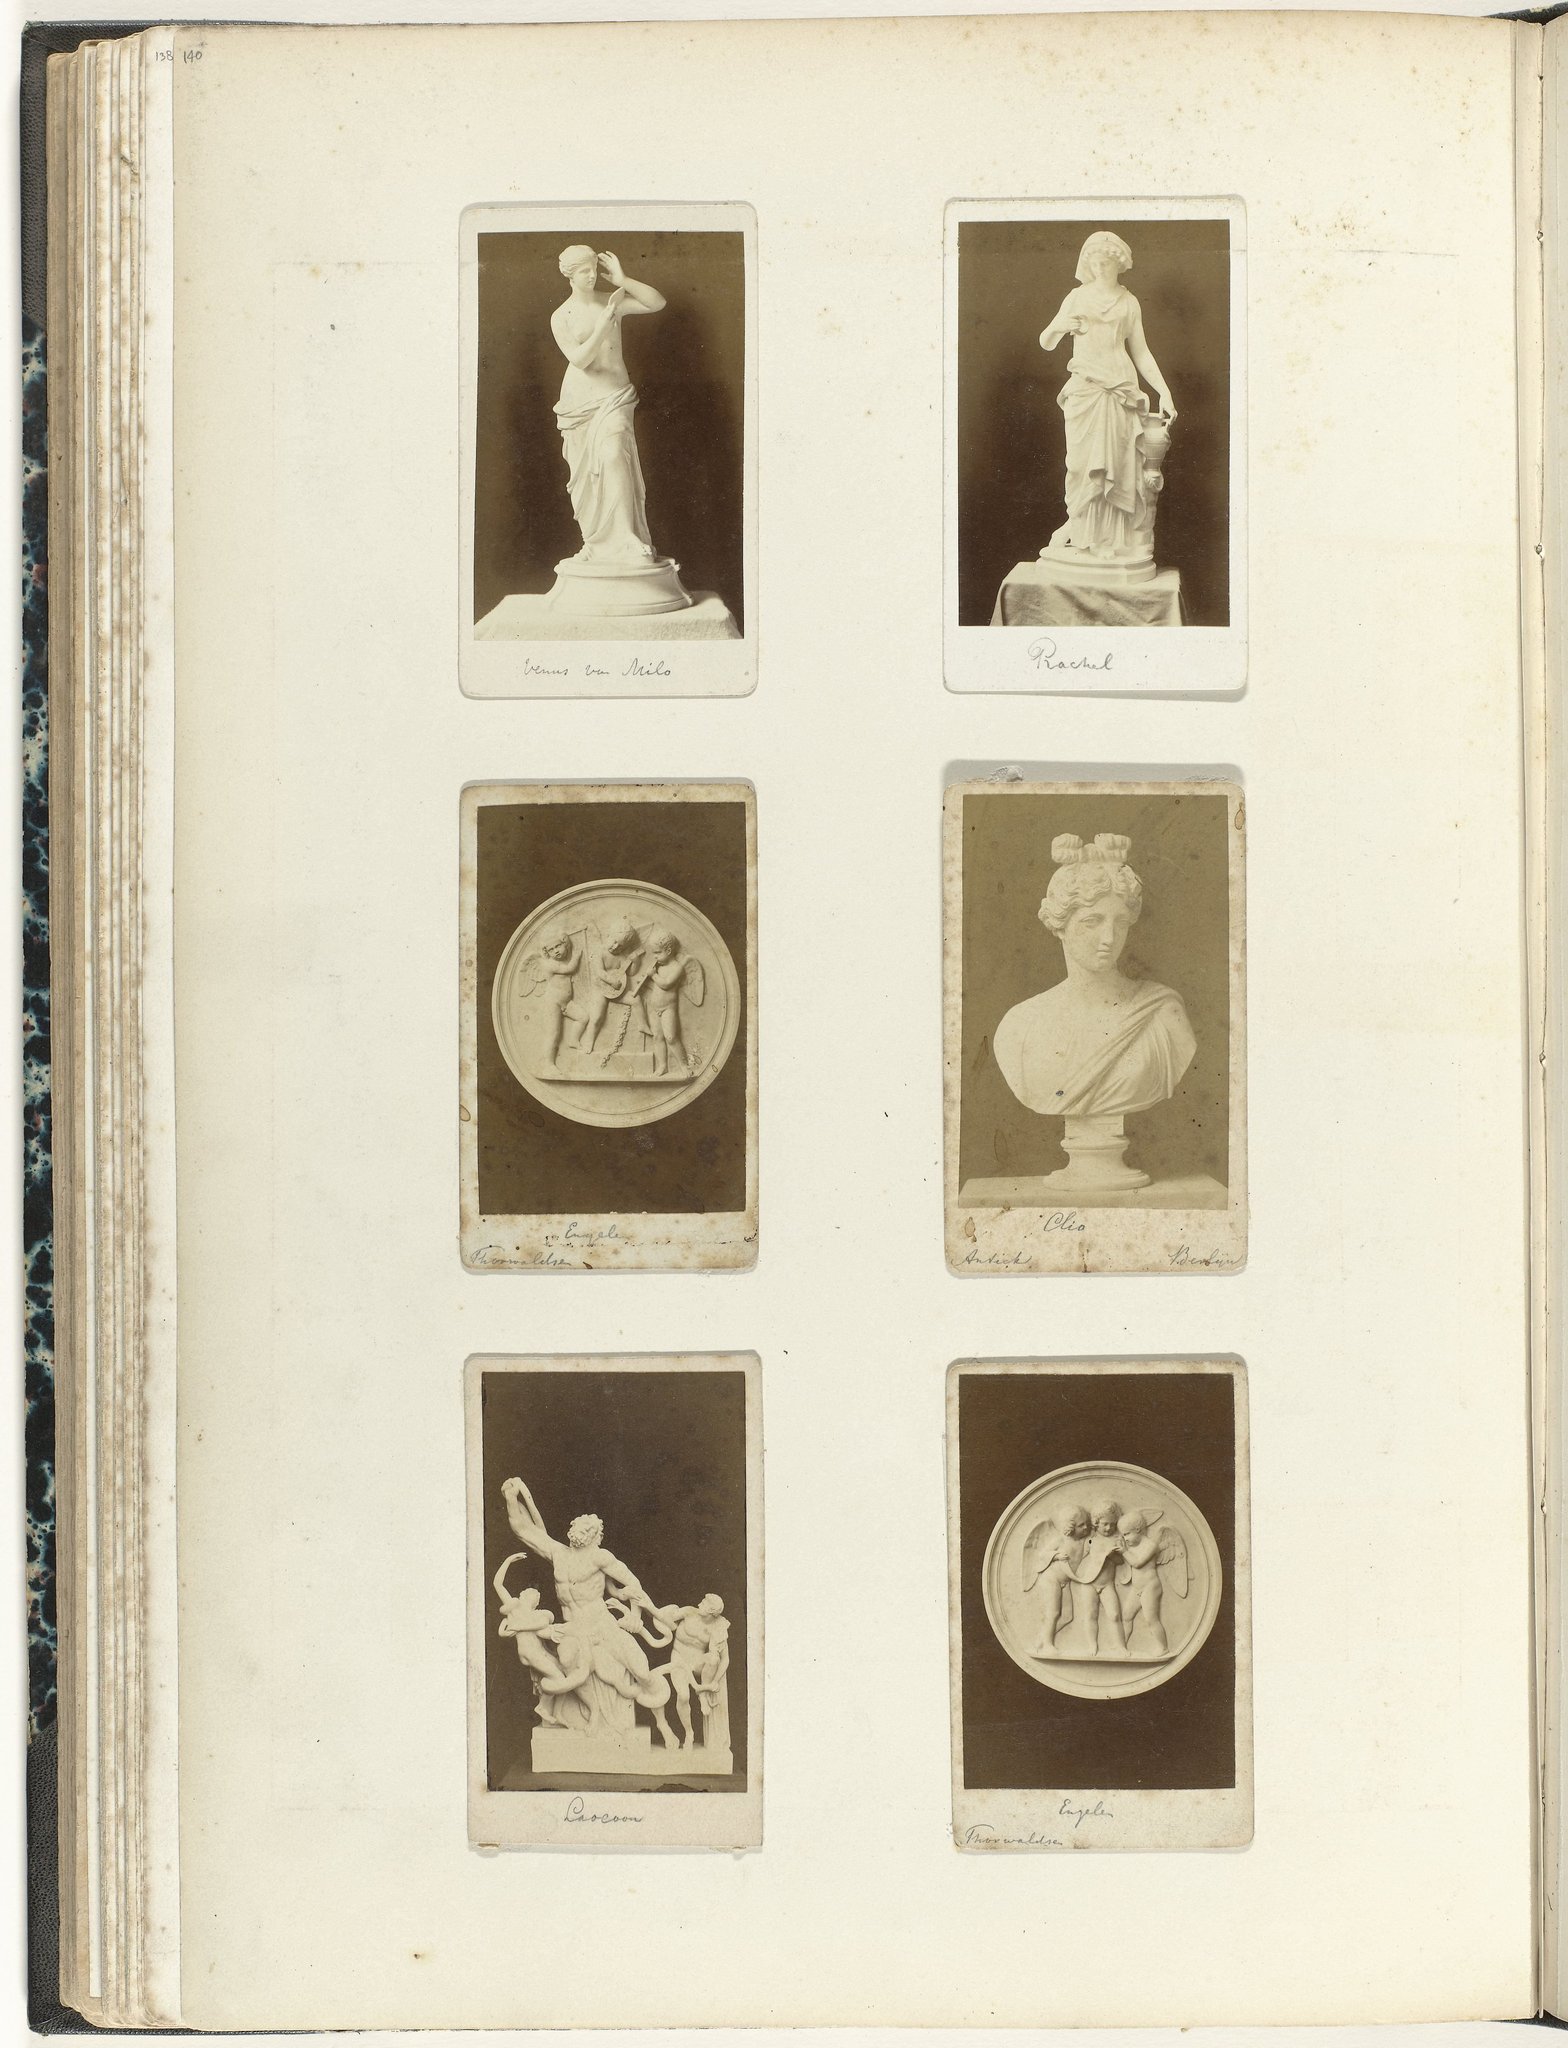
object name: carte de visite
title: Zes cartes-de-visite met drie beelden, een buste en twee medaillons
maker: Anonymous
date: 1866-1900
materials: cardboard, paper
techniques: albumen print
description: Beelden van Venus van Milo, Rachel, Laocoön, een buste van Clio en medaillons met drie engeltjes. Onderaan de cartes-de-visite staat met potlood geschreven wat er afgebeeld is, bij de medaillons staat linksonder de naam Thorwaldsen vermeld. Op de achterkant van het kaartje met Clio staat gedrukt: No. 1868. Clio. antik. Original im Berliner Museum.